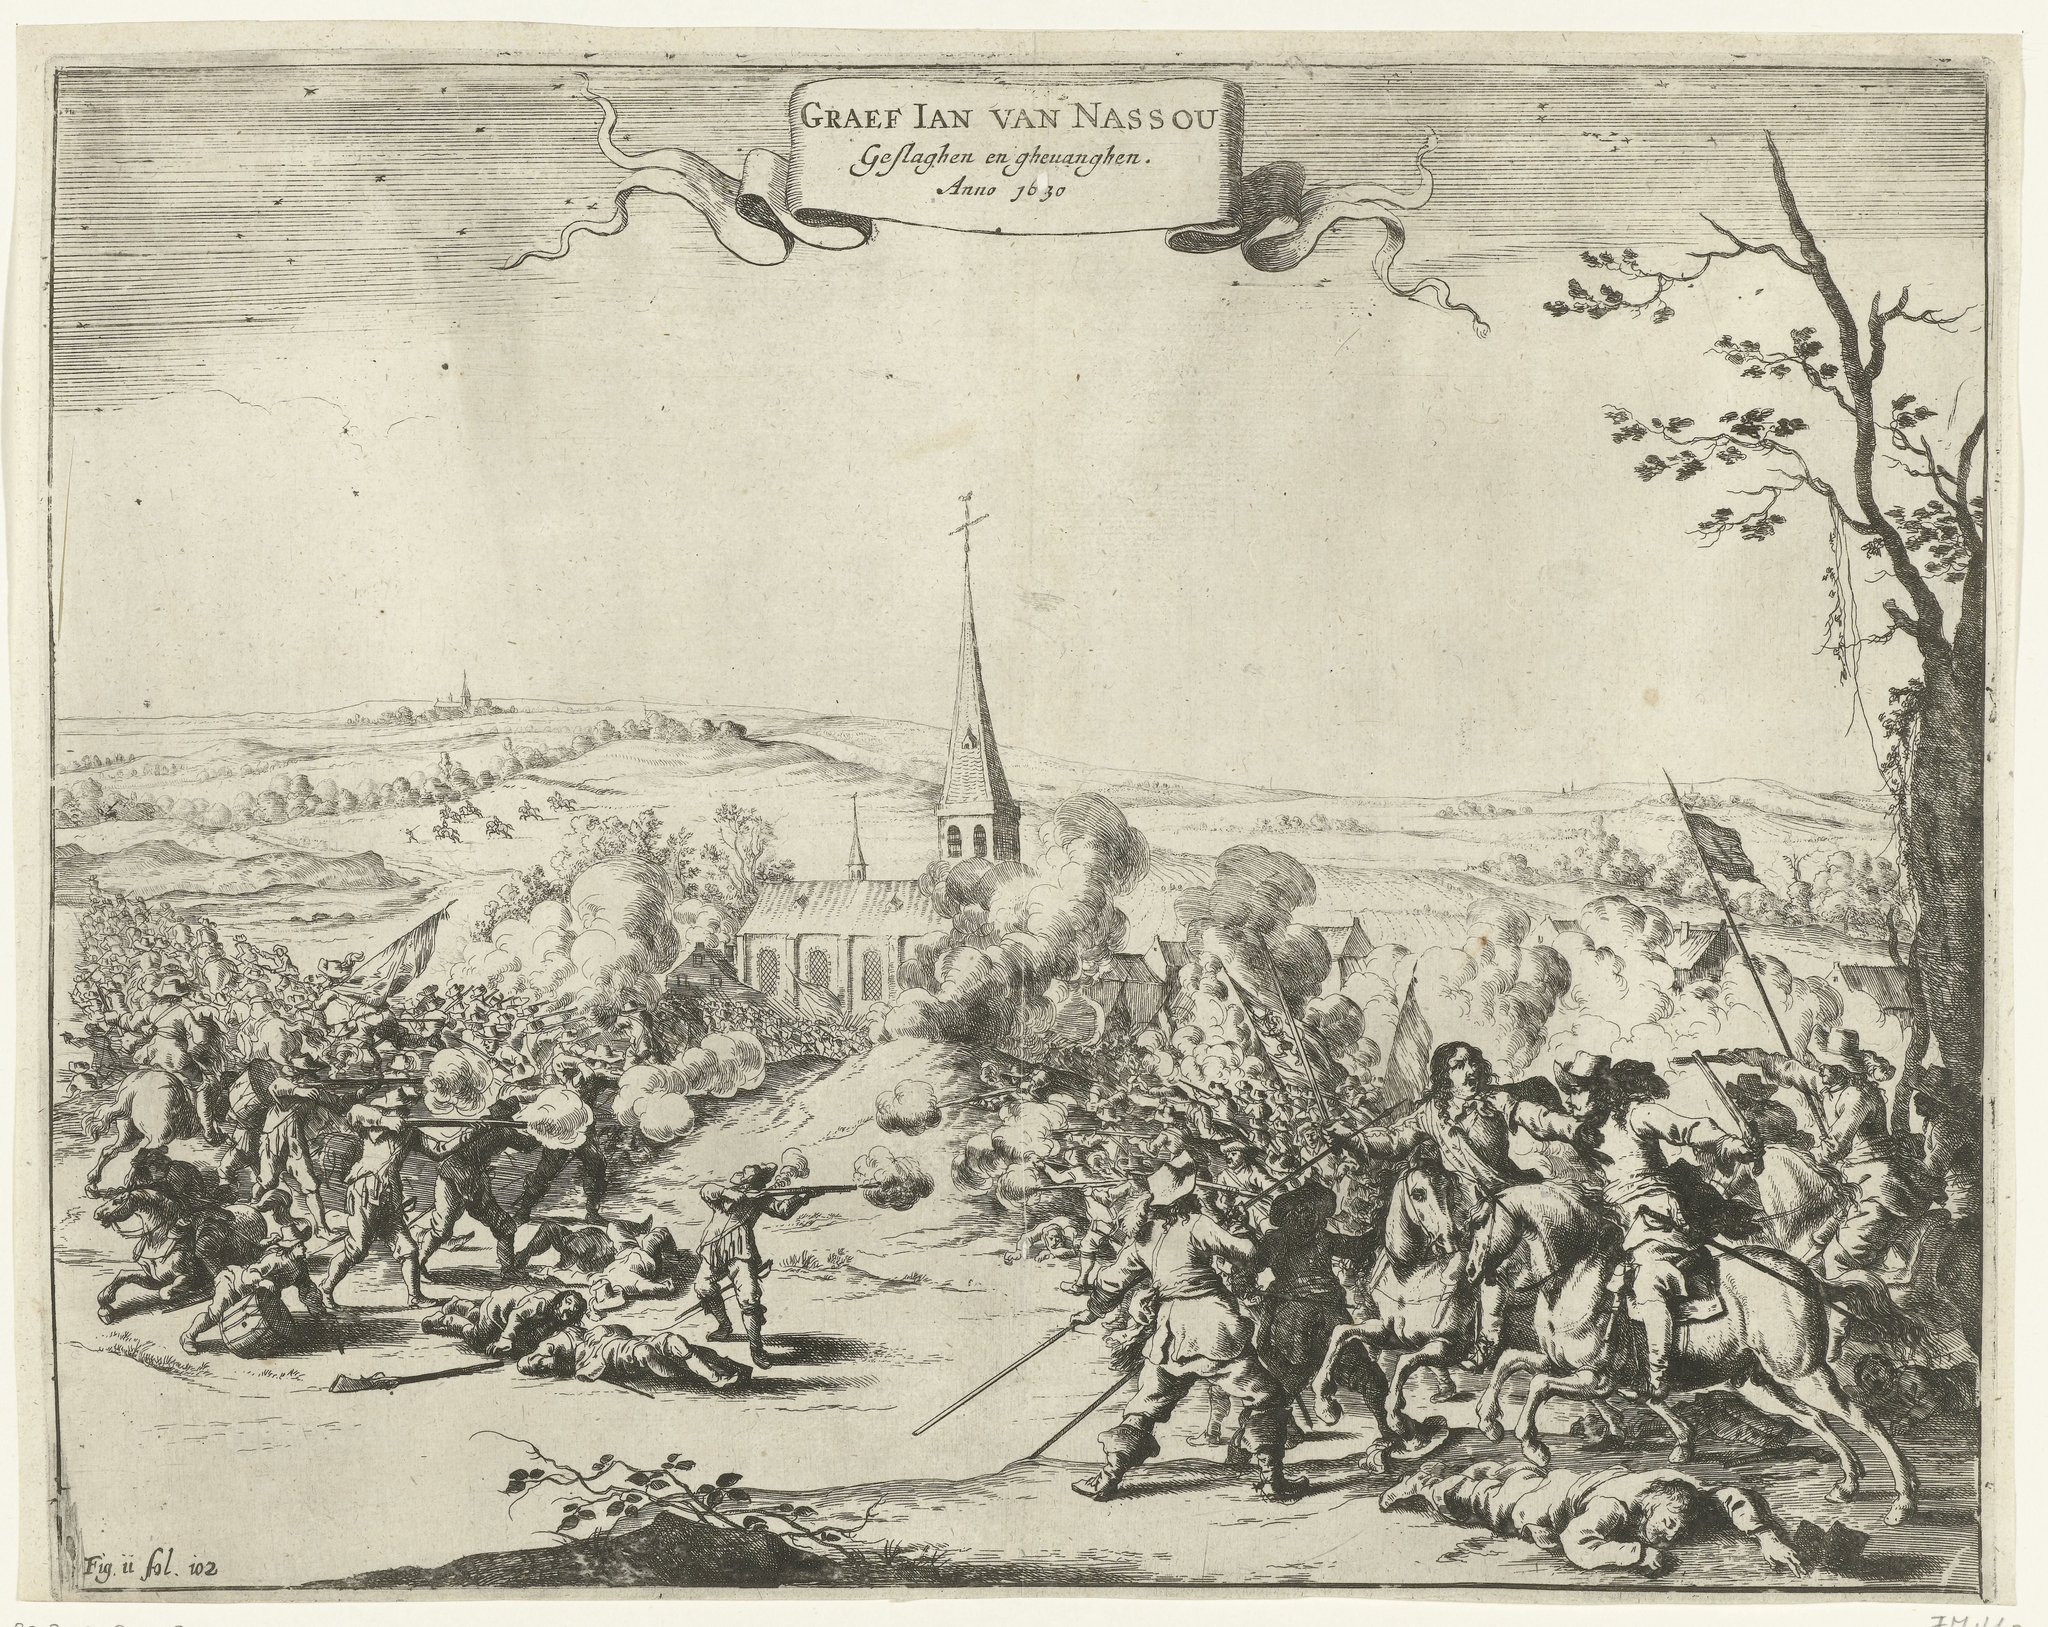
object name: history print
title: Gevangenneming van Johan VIII, graaf van Nassau-Siegen tijdens gevechten bij Wesel, 1630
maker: dirk stoop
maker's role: draughtsman, painter, print maker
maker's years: 1615-1686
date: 1651-1652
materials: paper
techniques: etching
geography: northern netherlands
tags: battle (+ land forces)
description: Gevangenneming van Johan VIII, graaf van Nassau-Siegen door kolonel Ysselstein tijdens gevechten bij Wesel, augustus 1630. Hevige gevechten in een landschap voor een kerk, rechts op de voorgrond wordt de graaf te paard gevangengenomen. Gemerkt linksonder: fig. 11, fol. 102.